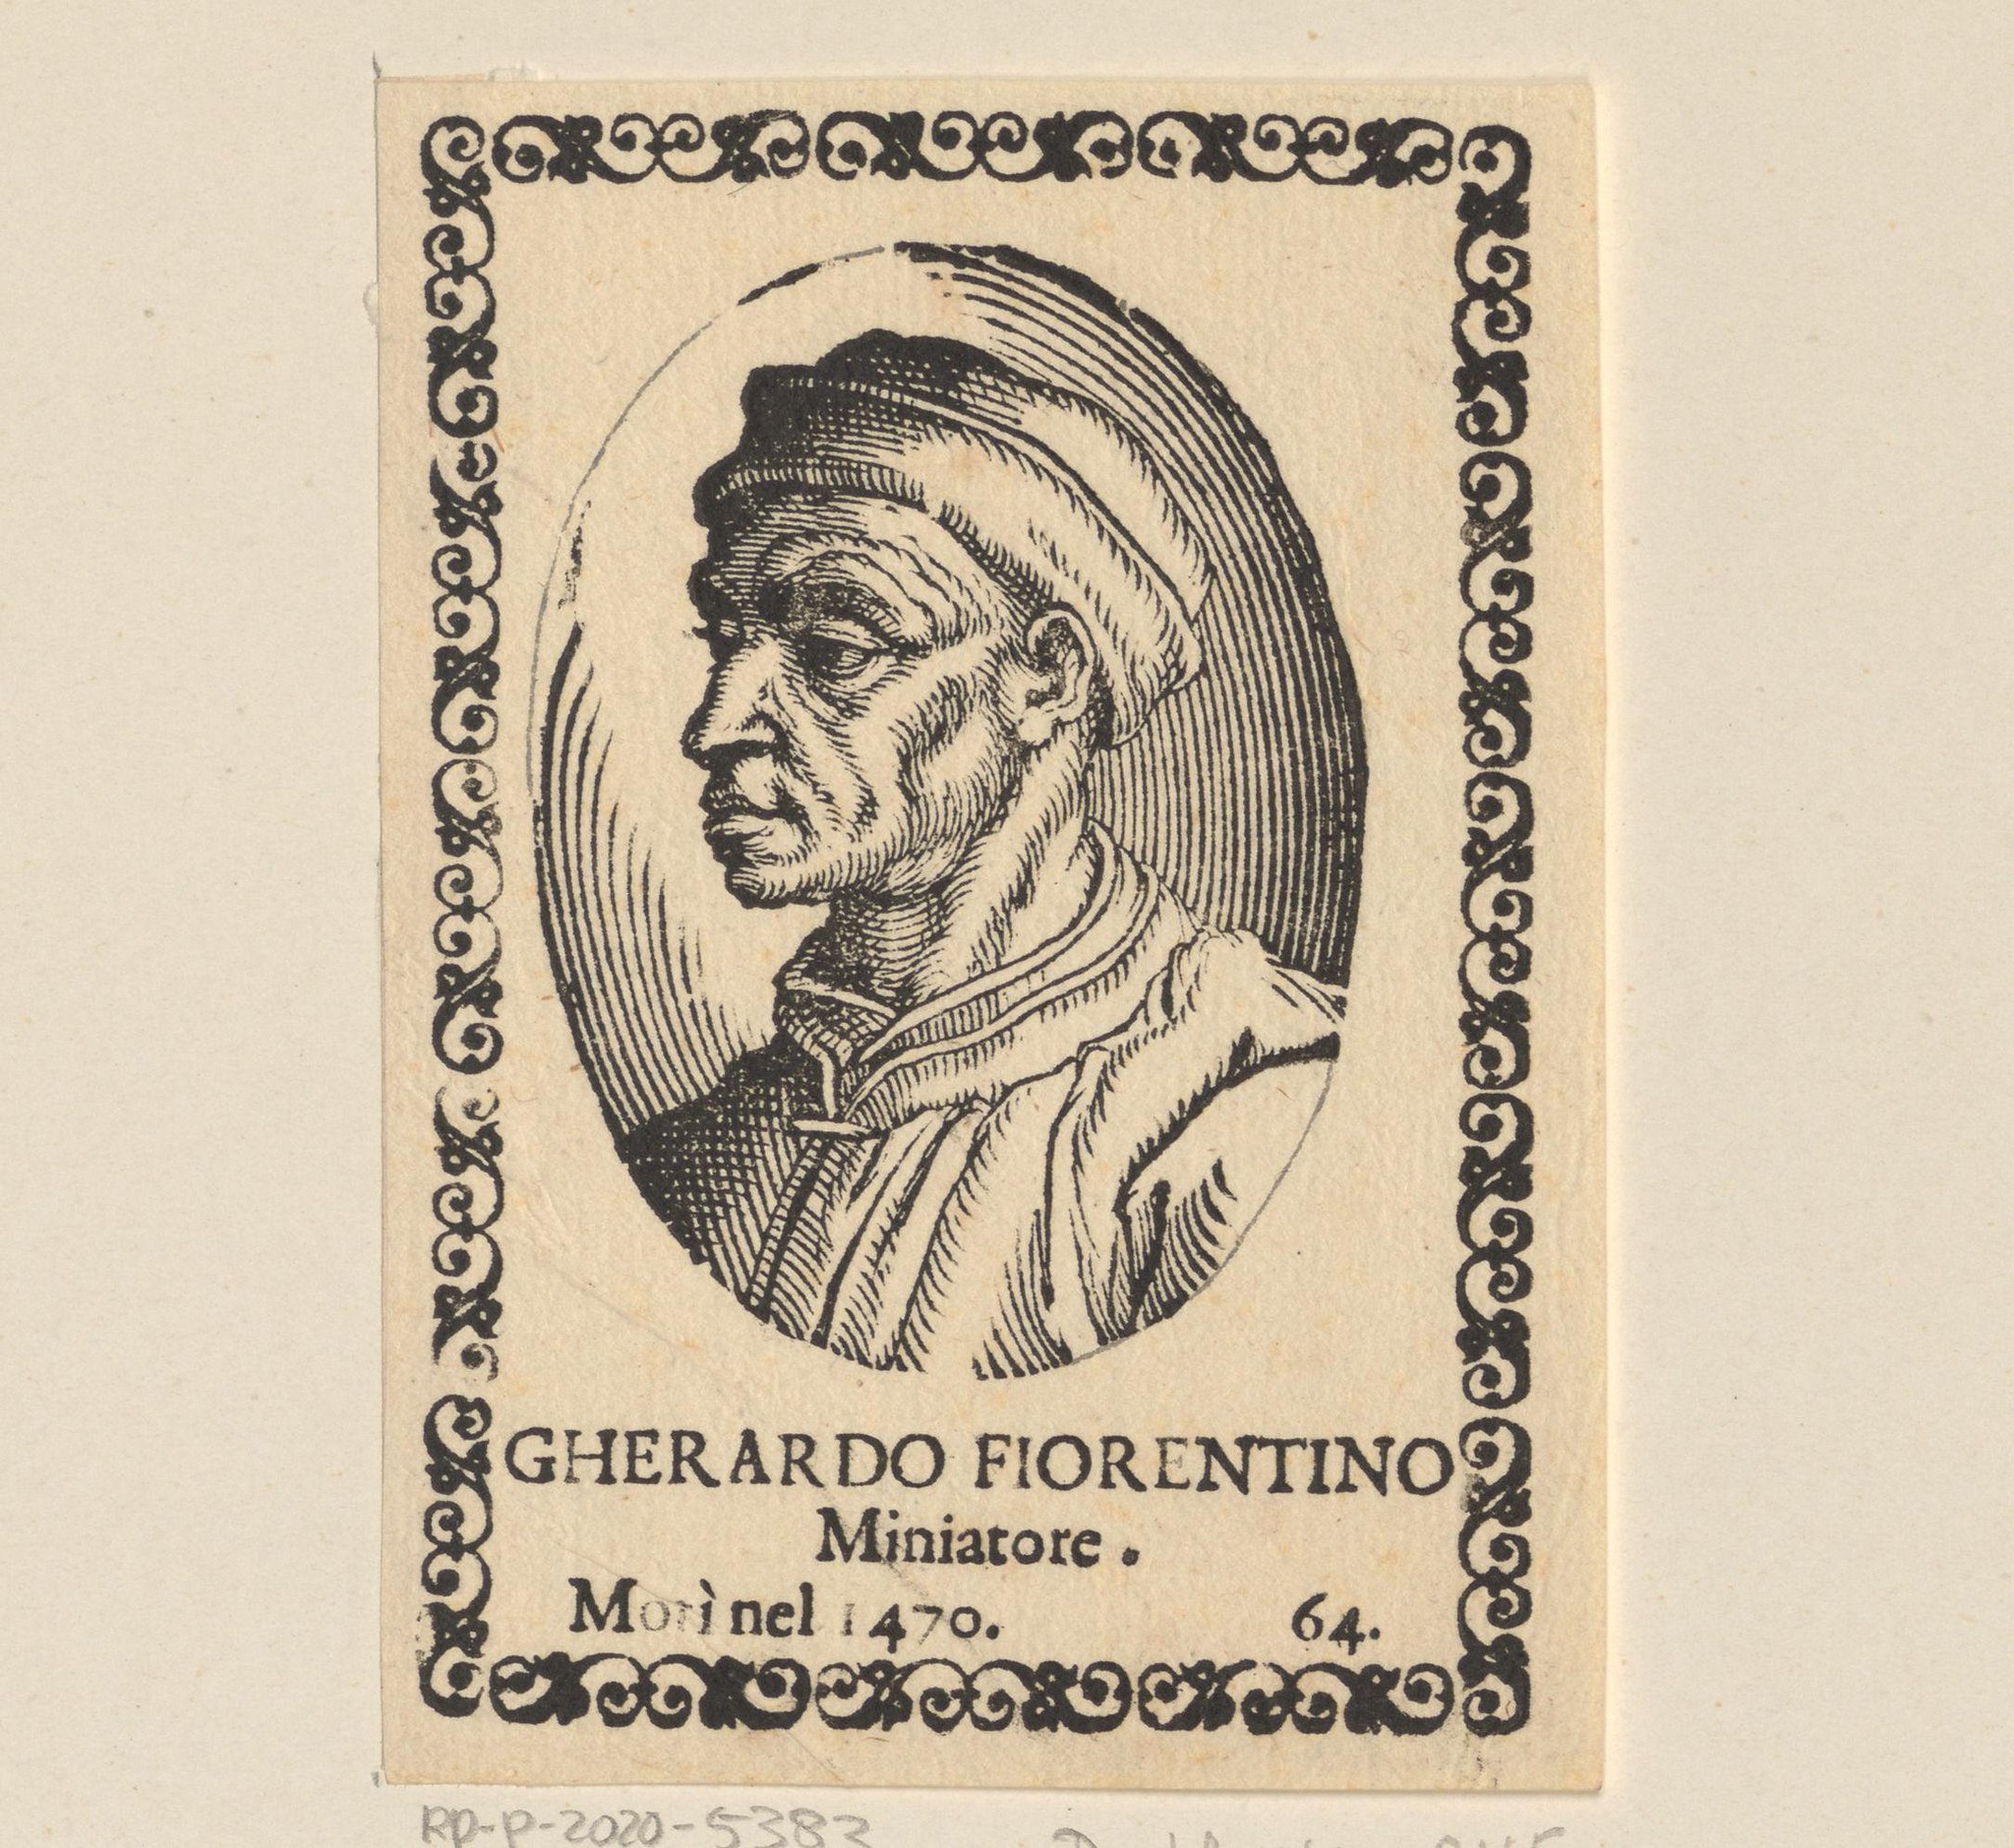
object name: print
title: Portret van Gherardo del Fora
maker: Anonymous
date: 1568-1650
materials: paper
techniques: letterpress printing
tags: historical persons, portrait, self-portrait of painter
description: Prent uit een onbekende editie van: Vasari, Giorgio. Le Vite de' più eccellenti pittori, scultori, e architettori da Cimabue insino a' tempi nostri. S.l.s.n., [1568]. De prent is met een andere omlijsting gebruikt in de editie uit 1568, en mogelijk in de editie uit 1647.